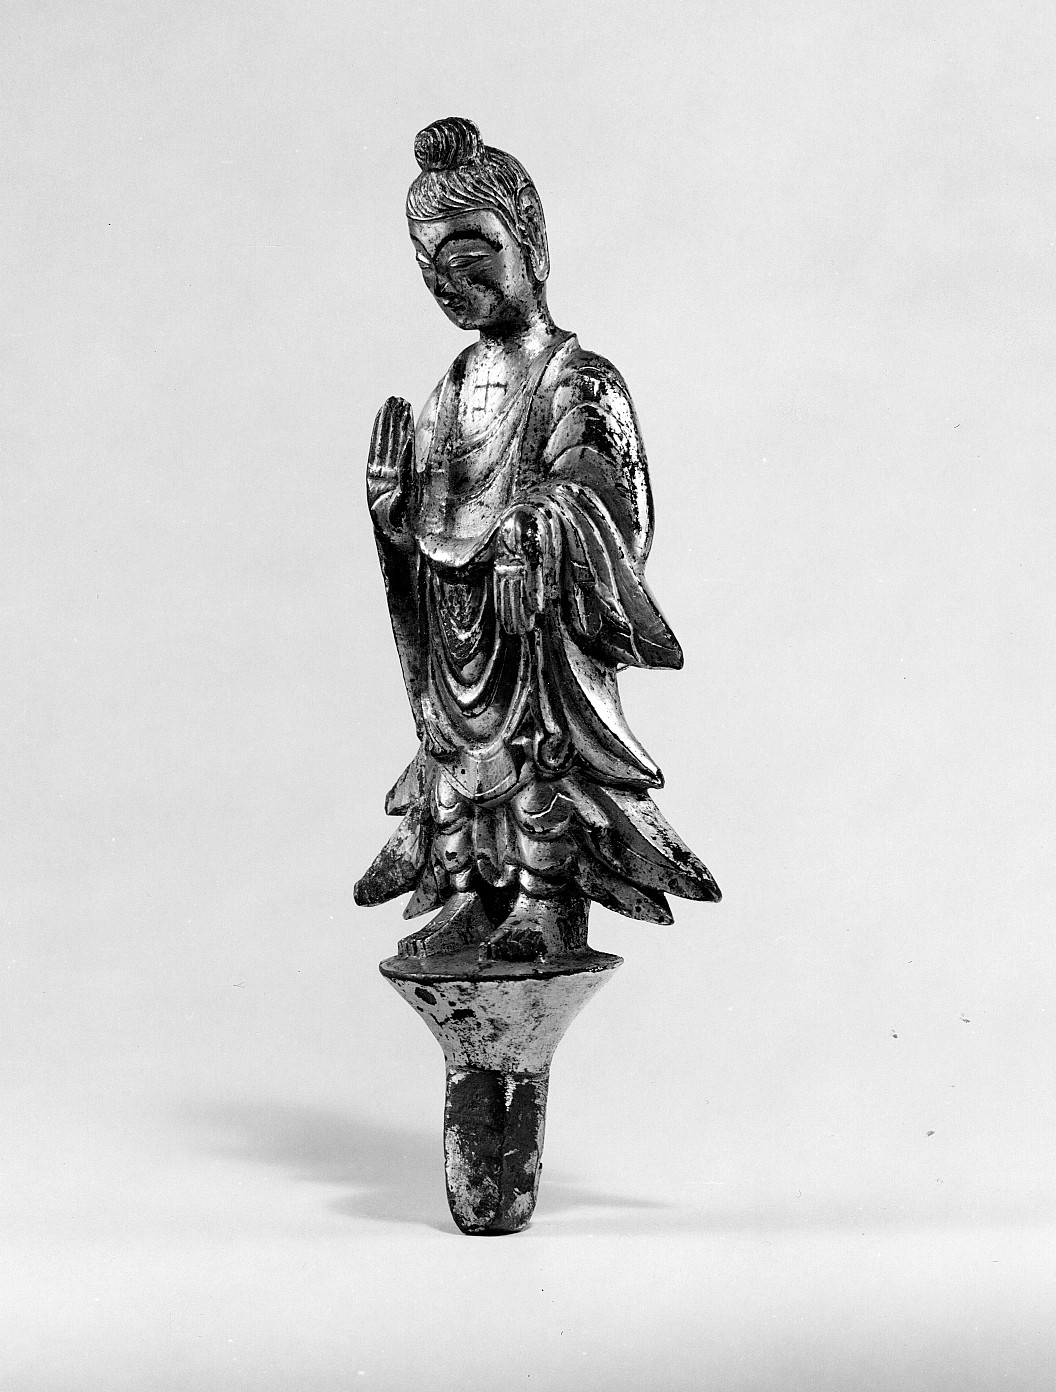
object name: figure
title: Buddha on a lotus pedestal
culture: chinese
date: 534-566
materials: gilt bronze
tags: buddhism,buddha